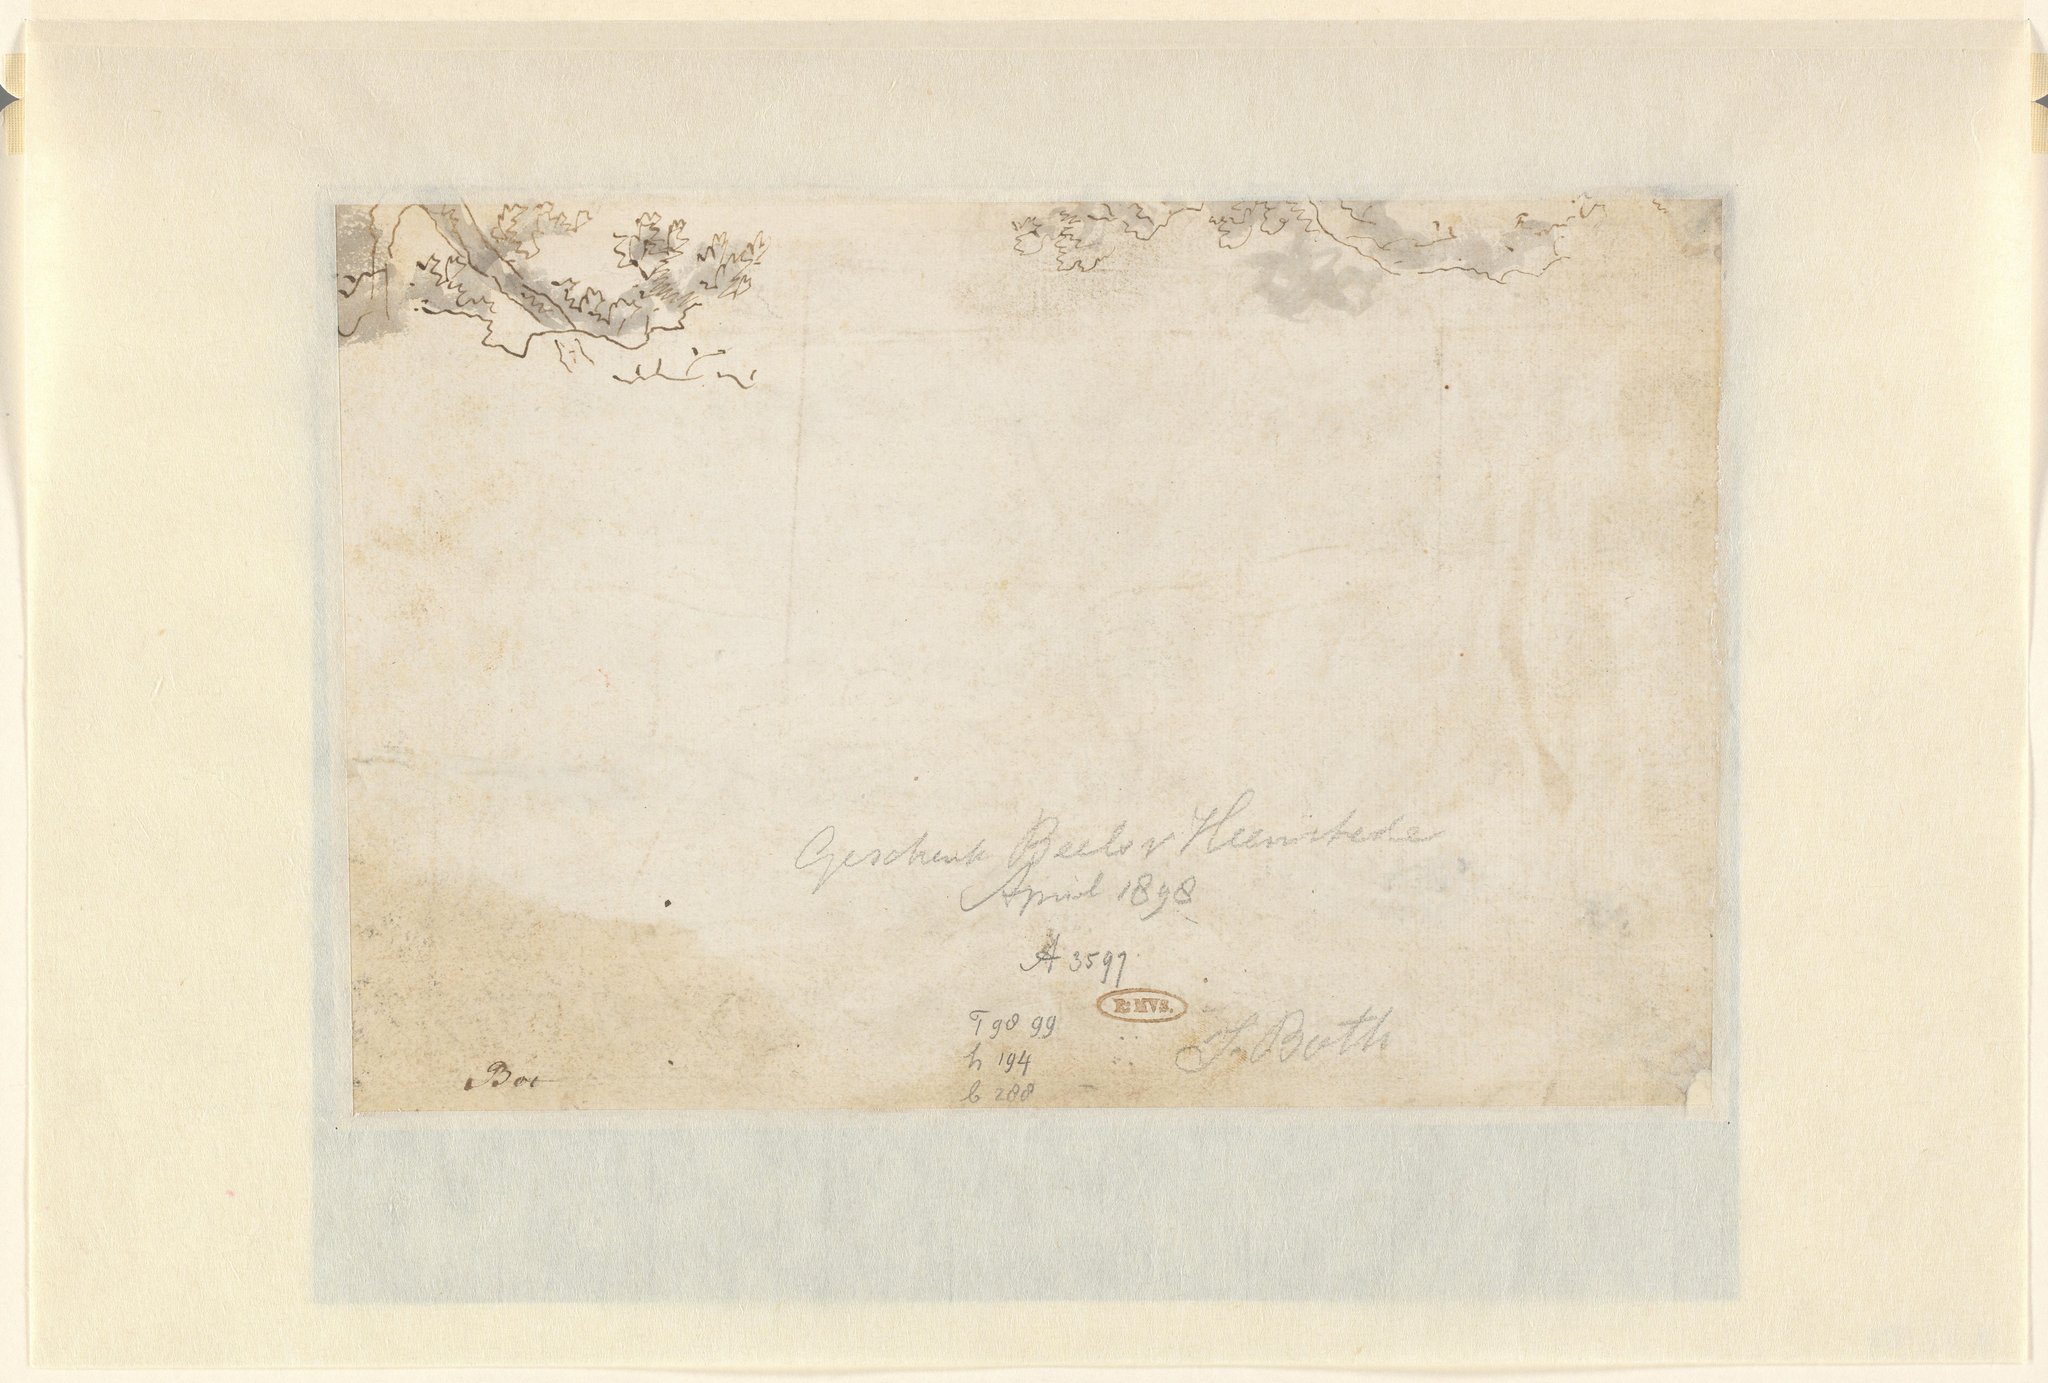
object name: drawing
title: Schetsen van bomen of gebladerte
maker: jan both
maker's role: draughtsman, painter, print maker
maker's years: 1618-1652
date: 1628-1652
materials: ink, paper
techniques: brush, pen